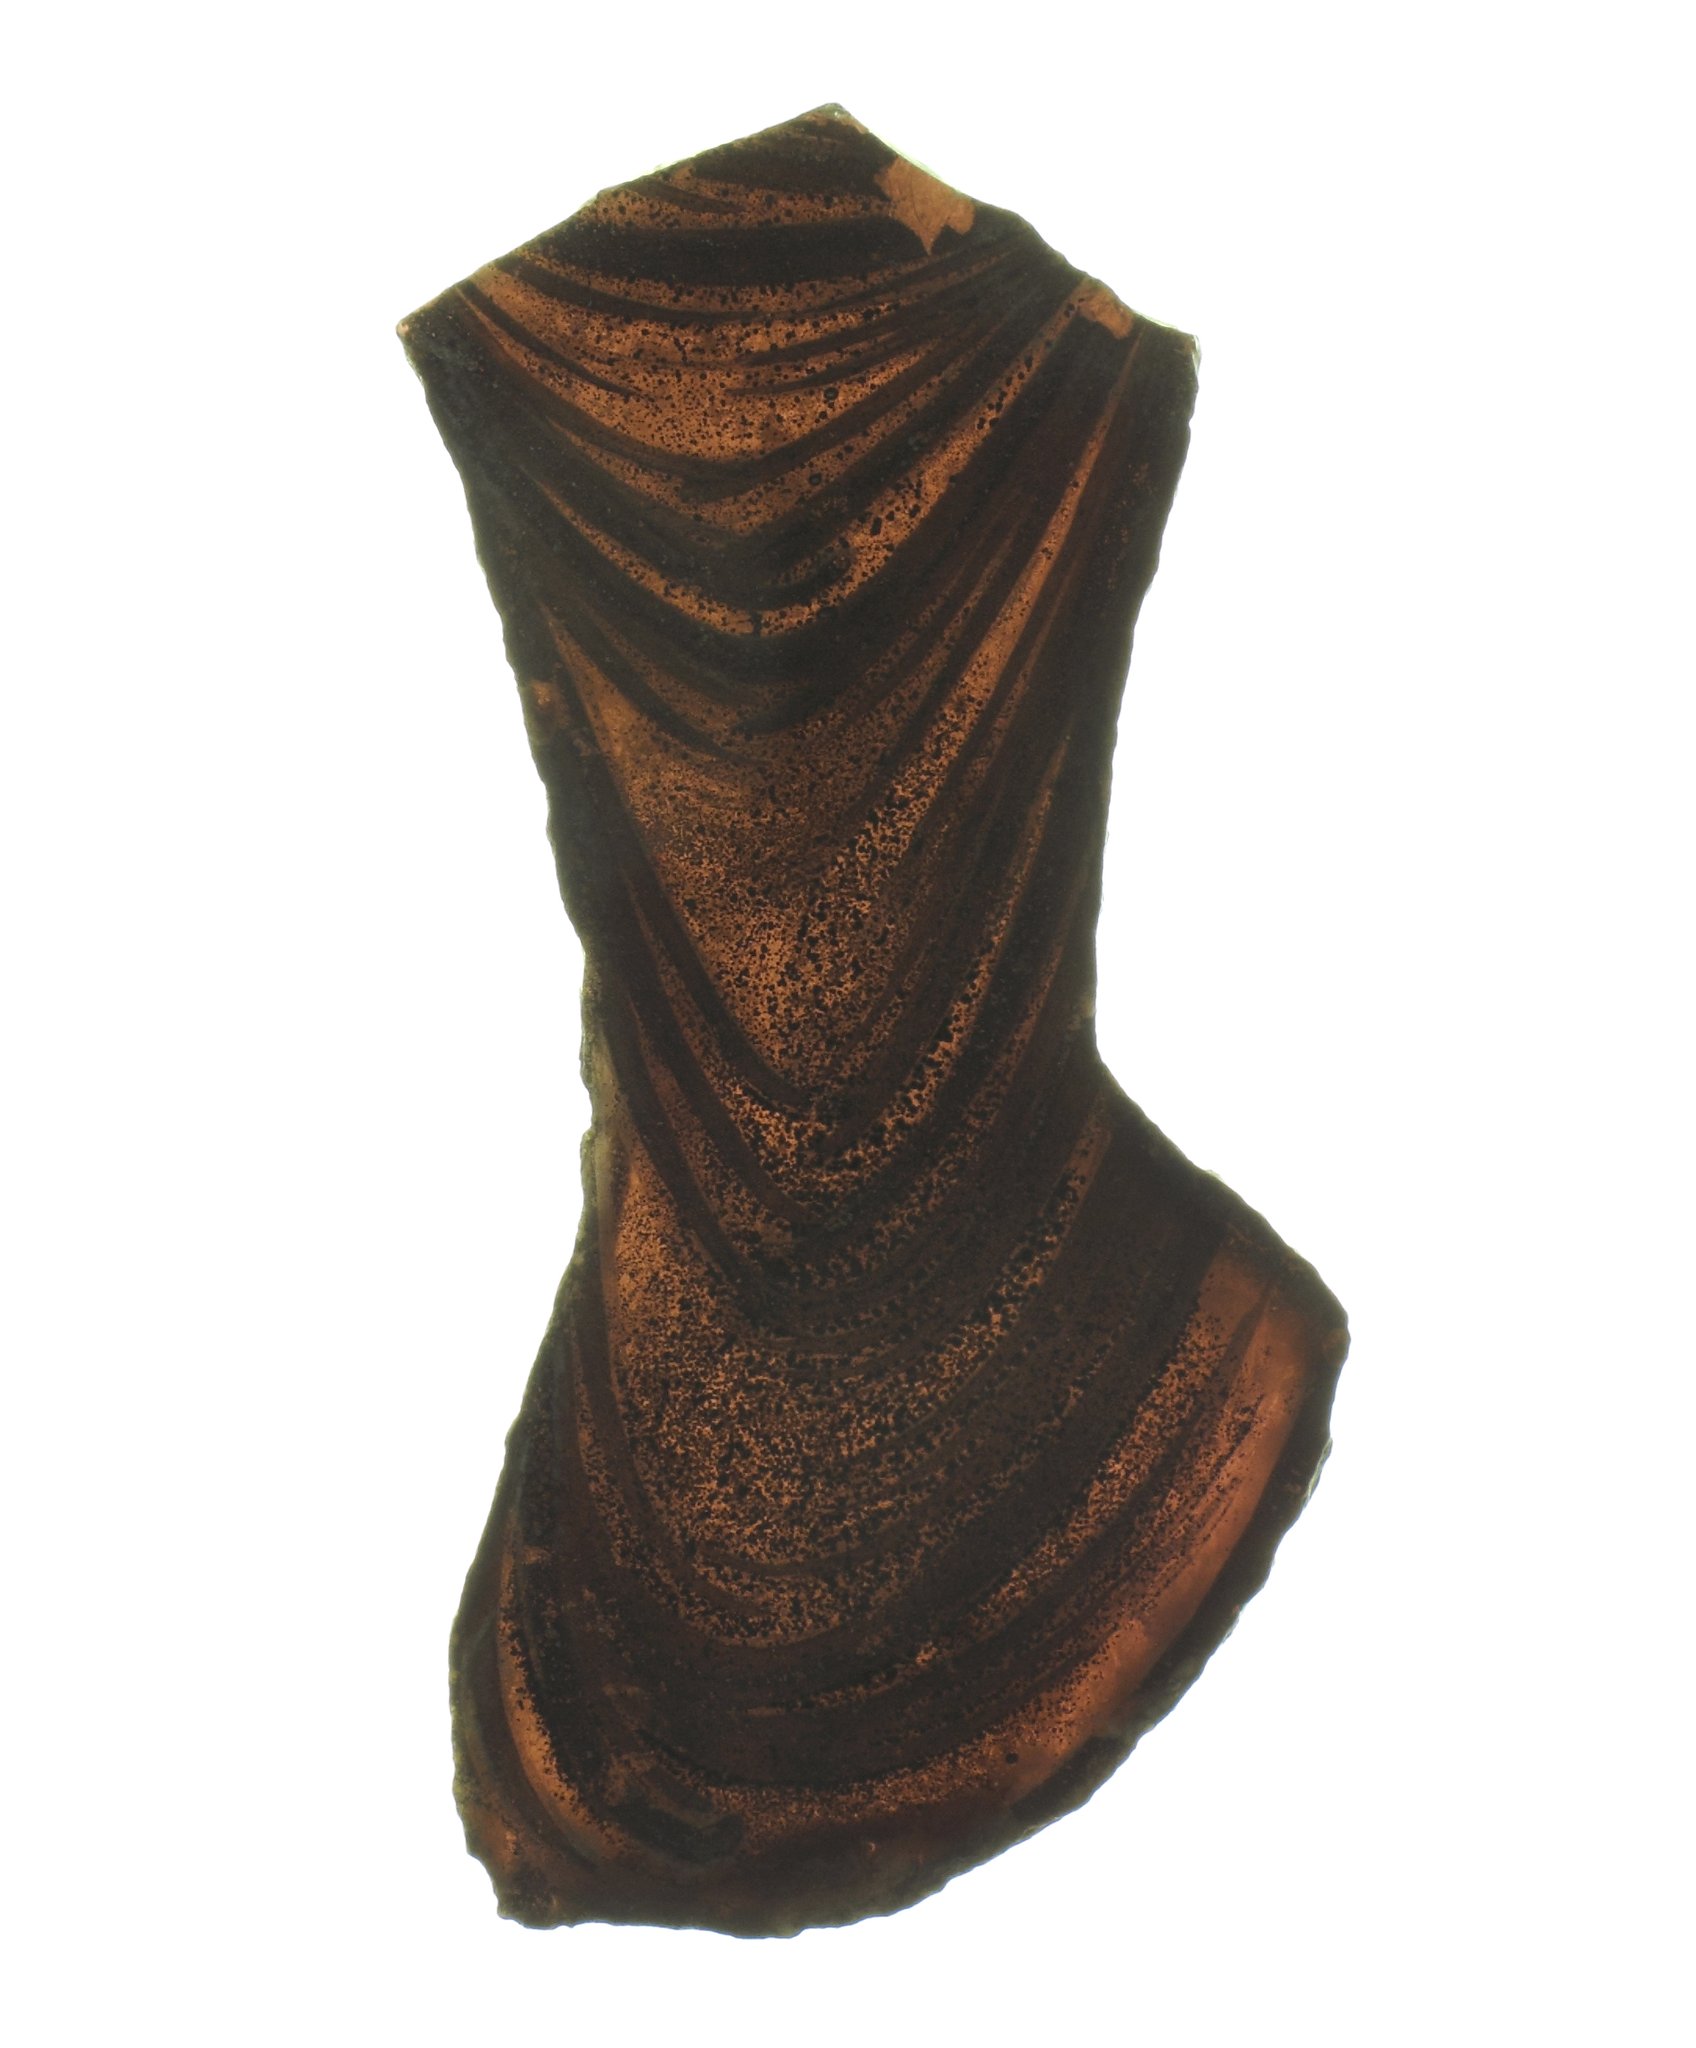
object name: fragment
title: Glass Fragment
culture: french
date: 1101-1400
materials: glass, metal, paint